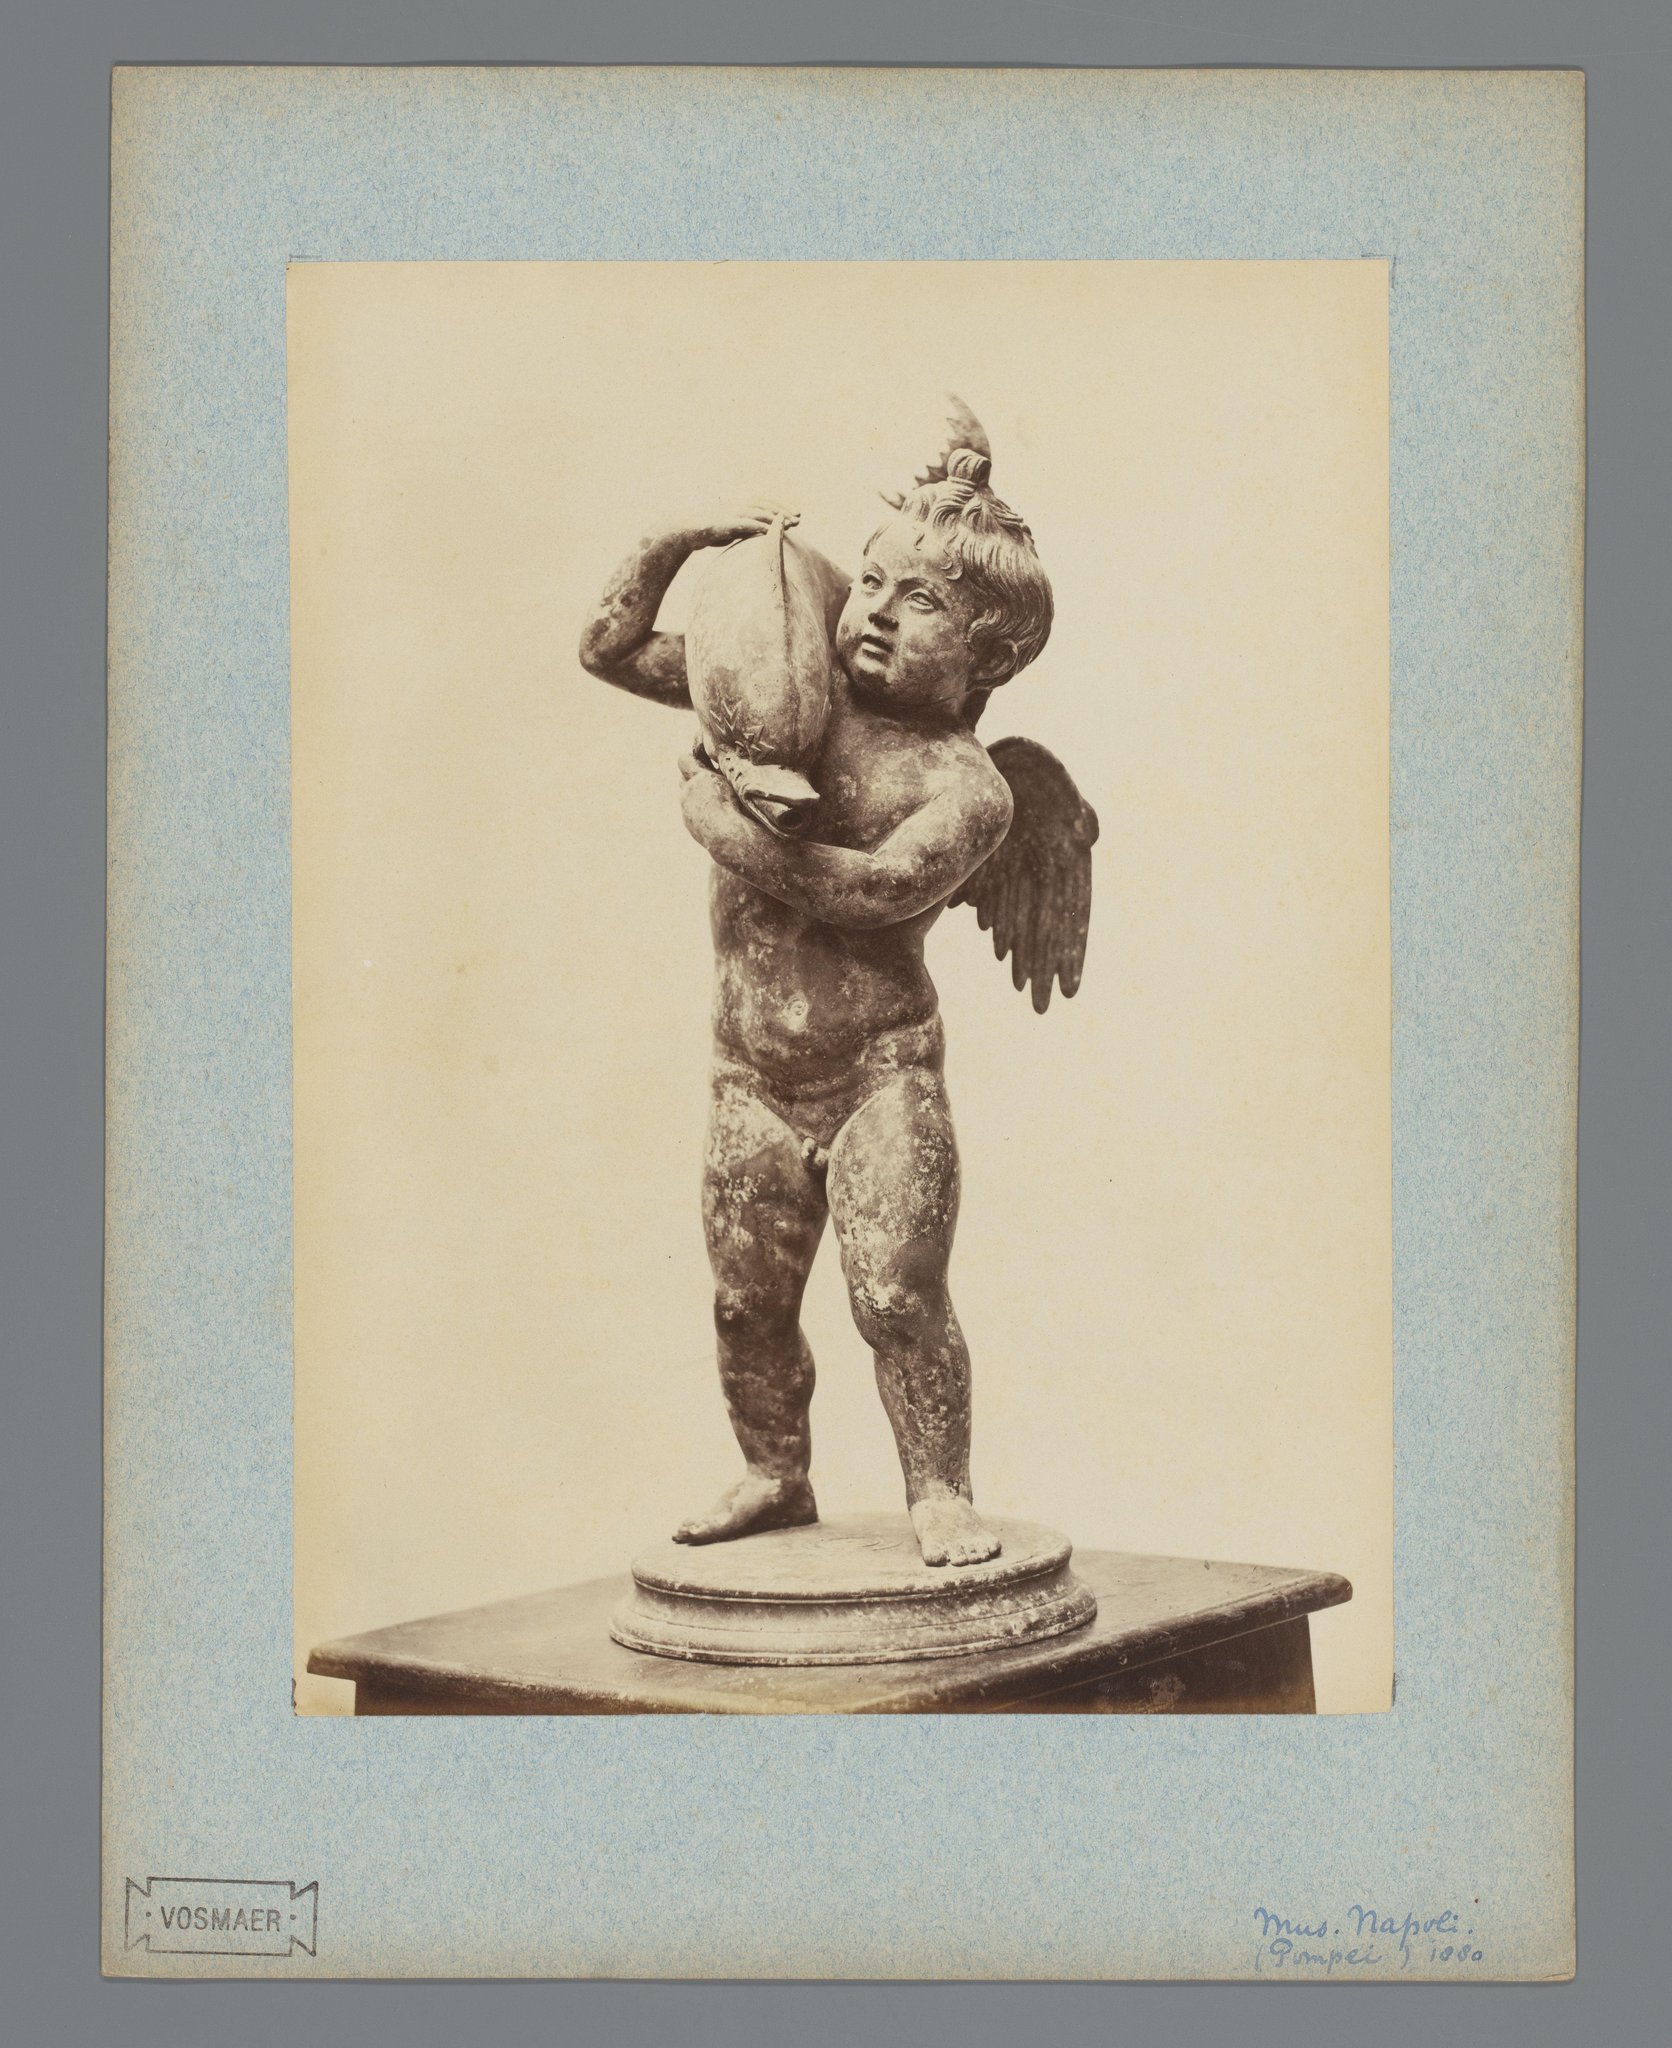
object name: photograph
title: Bronzen sculptuur, opgegraven in Pompeï, Italië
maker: Anonymous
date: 1880-1890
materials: cardboard, paper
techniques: albumen print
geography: naples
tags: sculpture, naples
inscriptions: inscription: ‘Mus. Napoli./ (Pompei) 1880’, collector's mark: ‘VOSMAER’